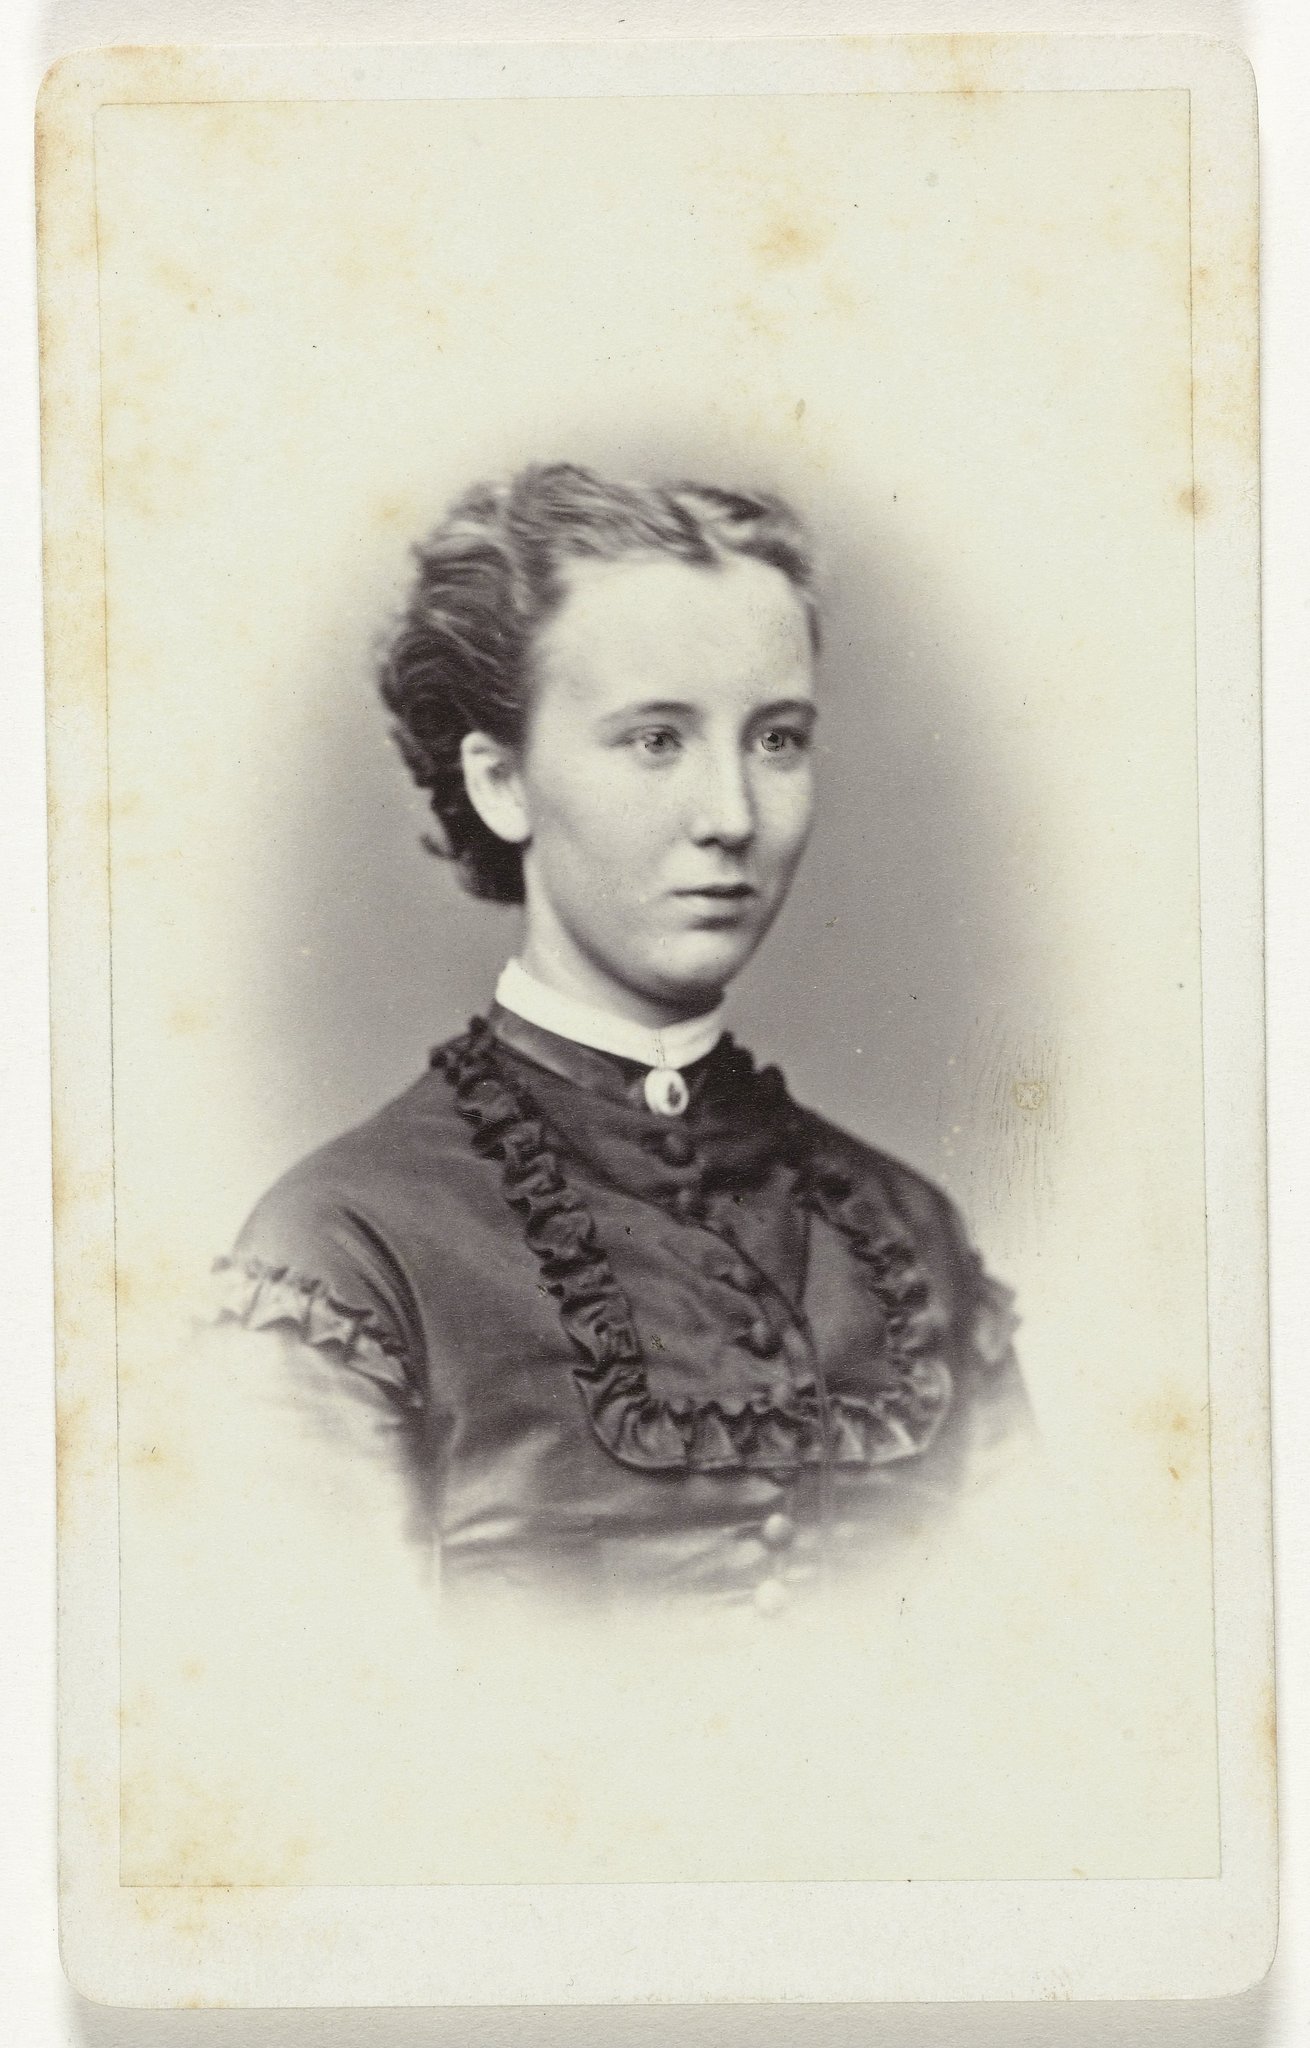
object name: carte de visite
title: Portret van een meisje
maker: jacob hohmann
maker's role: fotograaf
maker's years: 1833-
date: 1863-1870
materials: cardboard, paper, photographic support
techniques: albumen print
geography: the hague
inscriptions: annotation: ‘Voor nabestellingen worden alle negatieven bewaard.’, signature and address: ‘J. Hohmann/Photograaf/'s Gravenhage/Willemstraat 59’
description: Buste van meisje in donkere japon met wit boordje, driekwart naar rechts